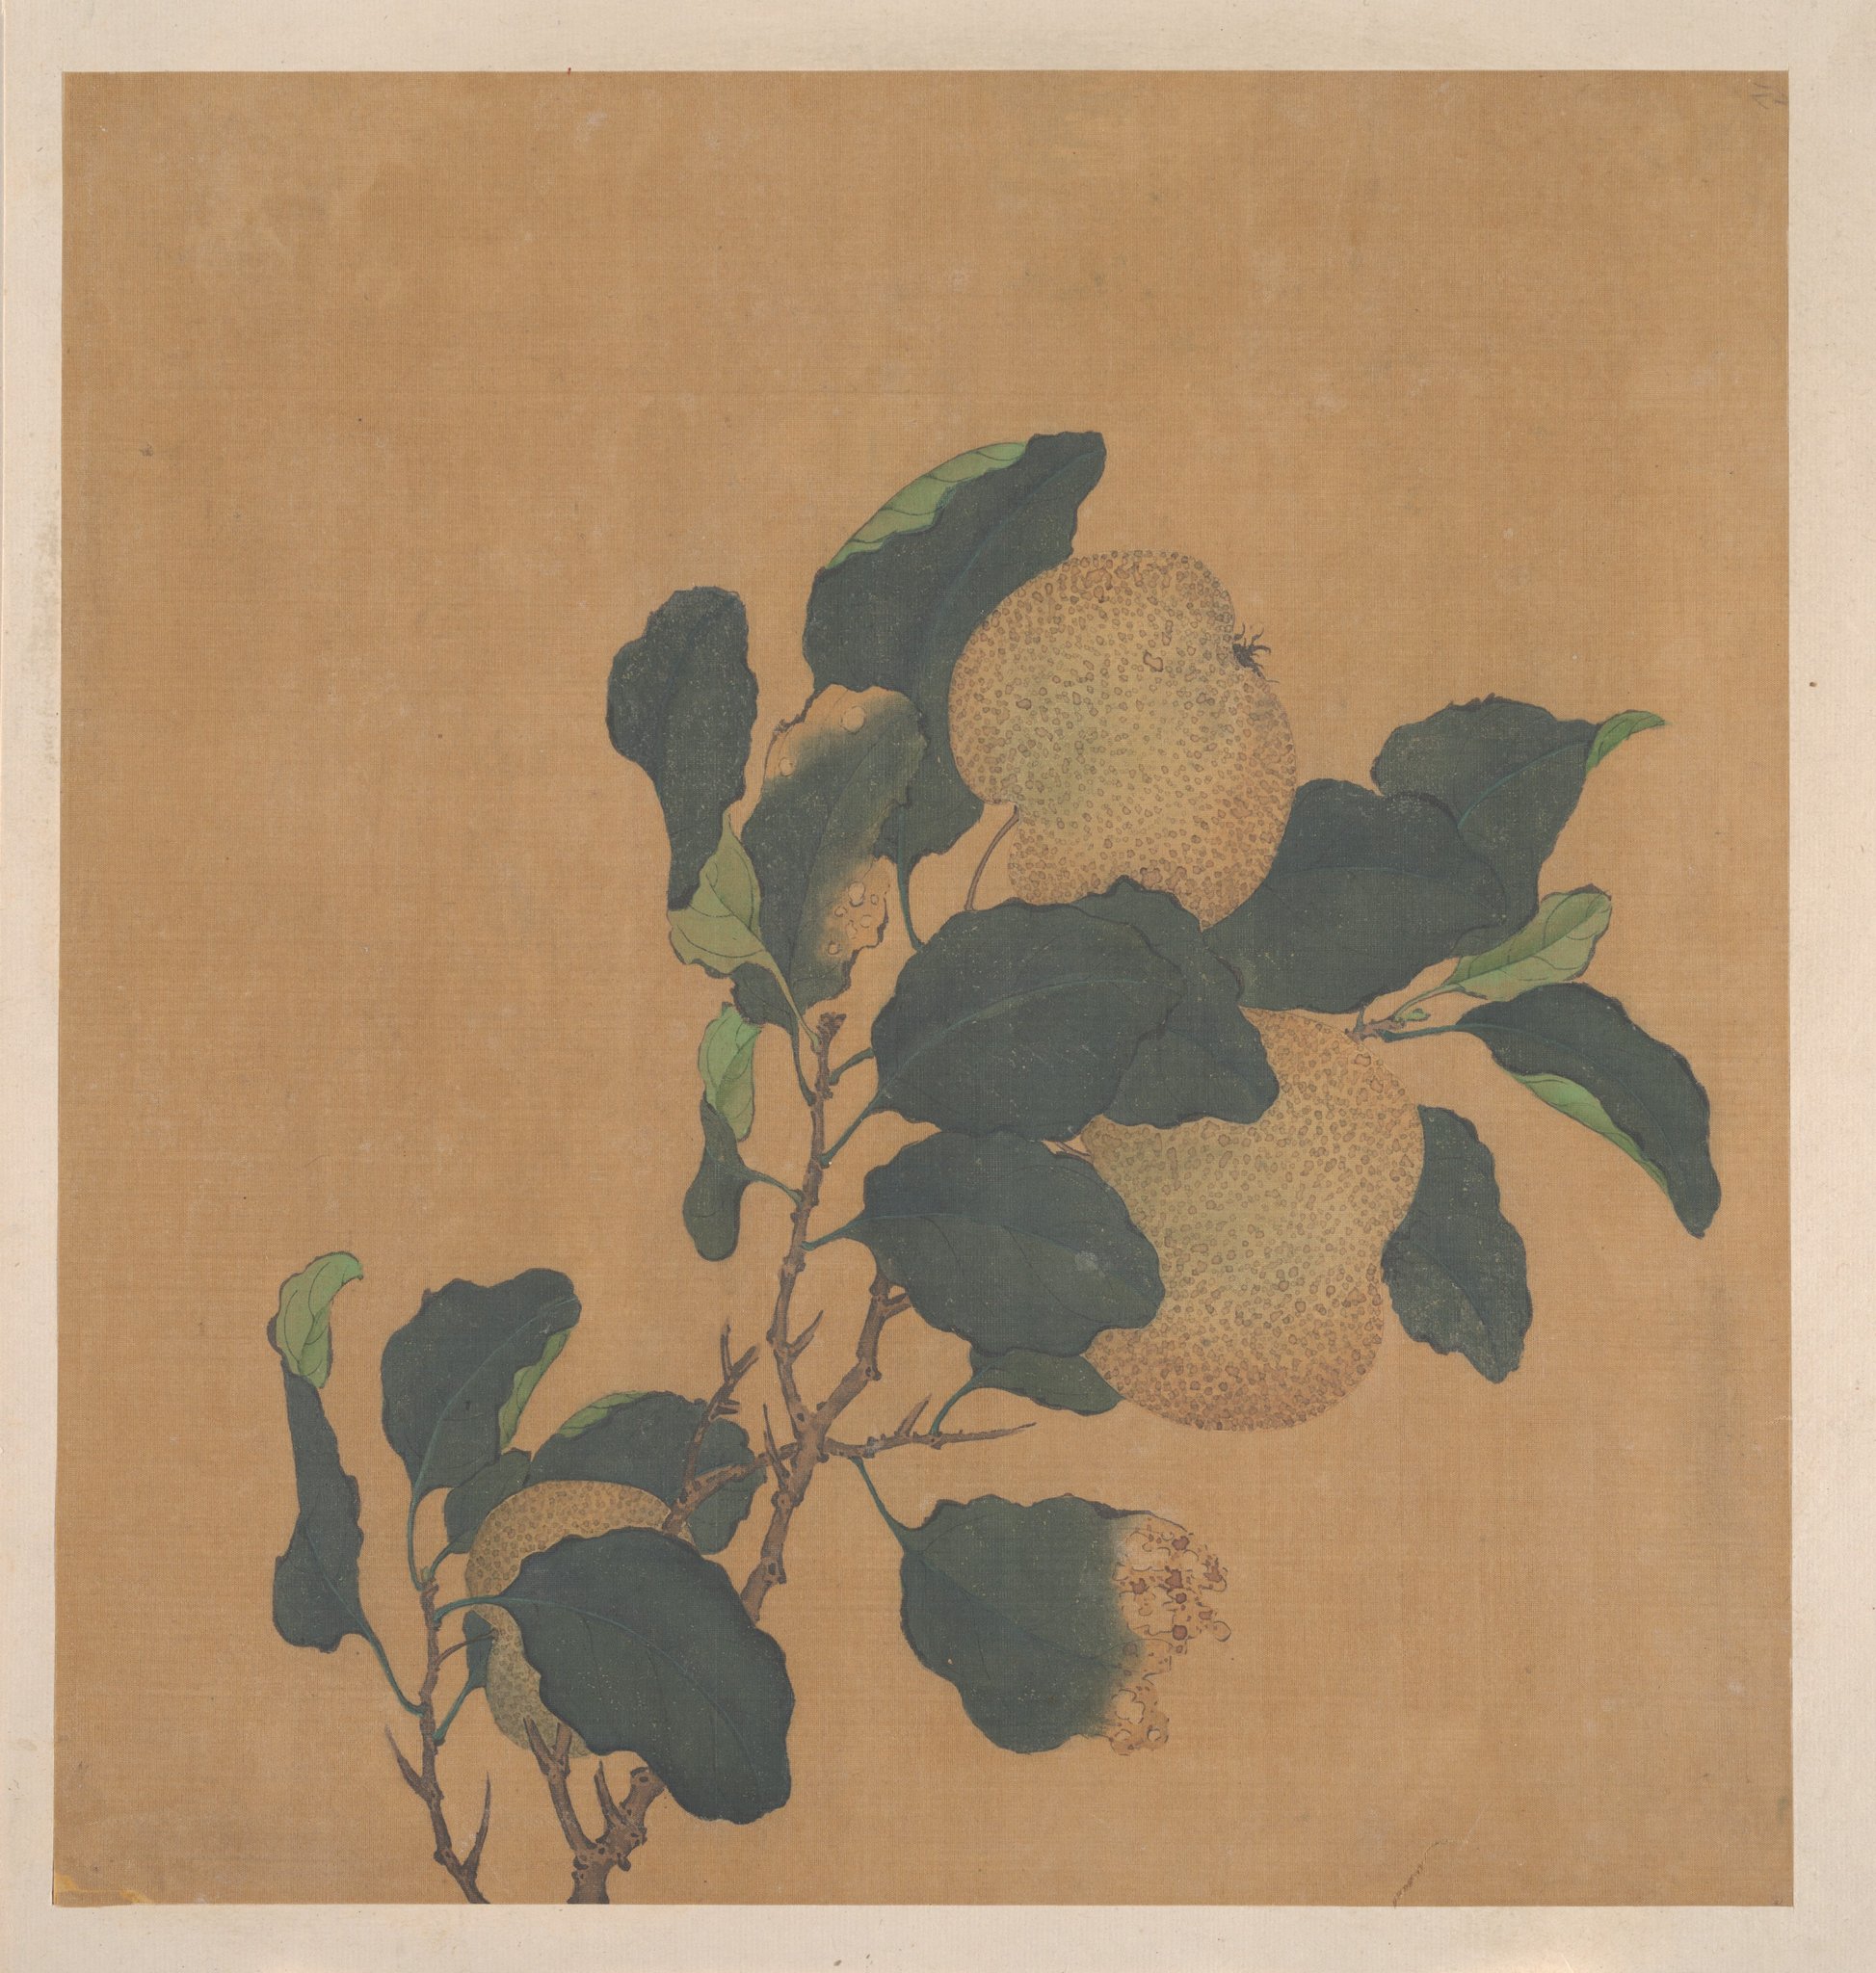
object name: album leaf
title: Branch of Tree with Fruit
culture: chinese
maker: unidentified artist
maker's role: artist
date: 1644-1911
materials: ink, silk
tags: fruit